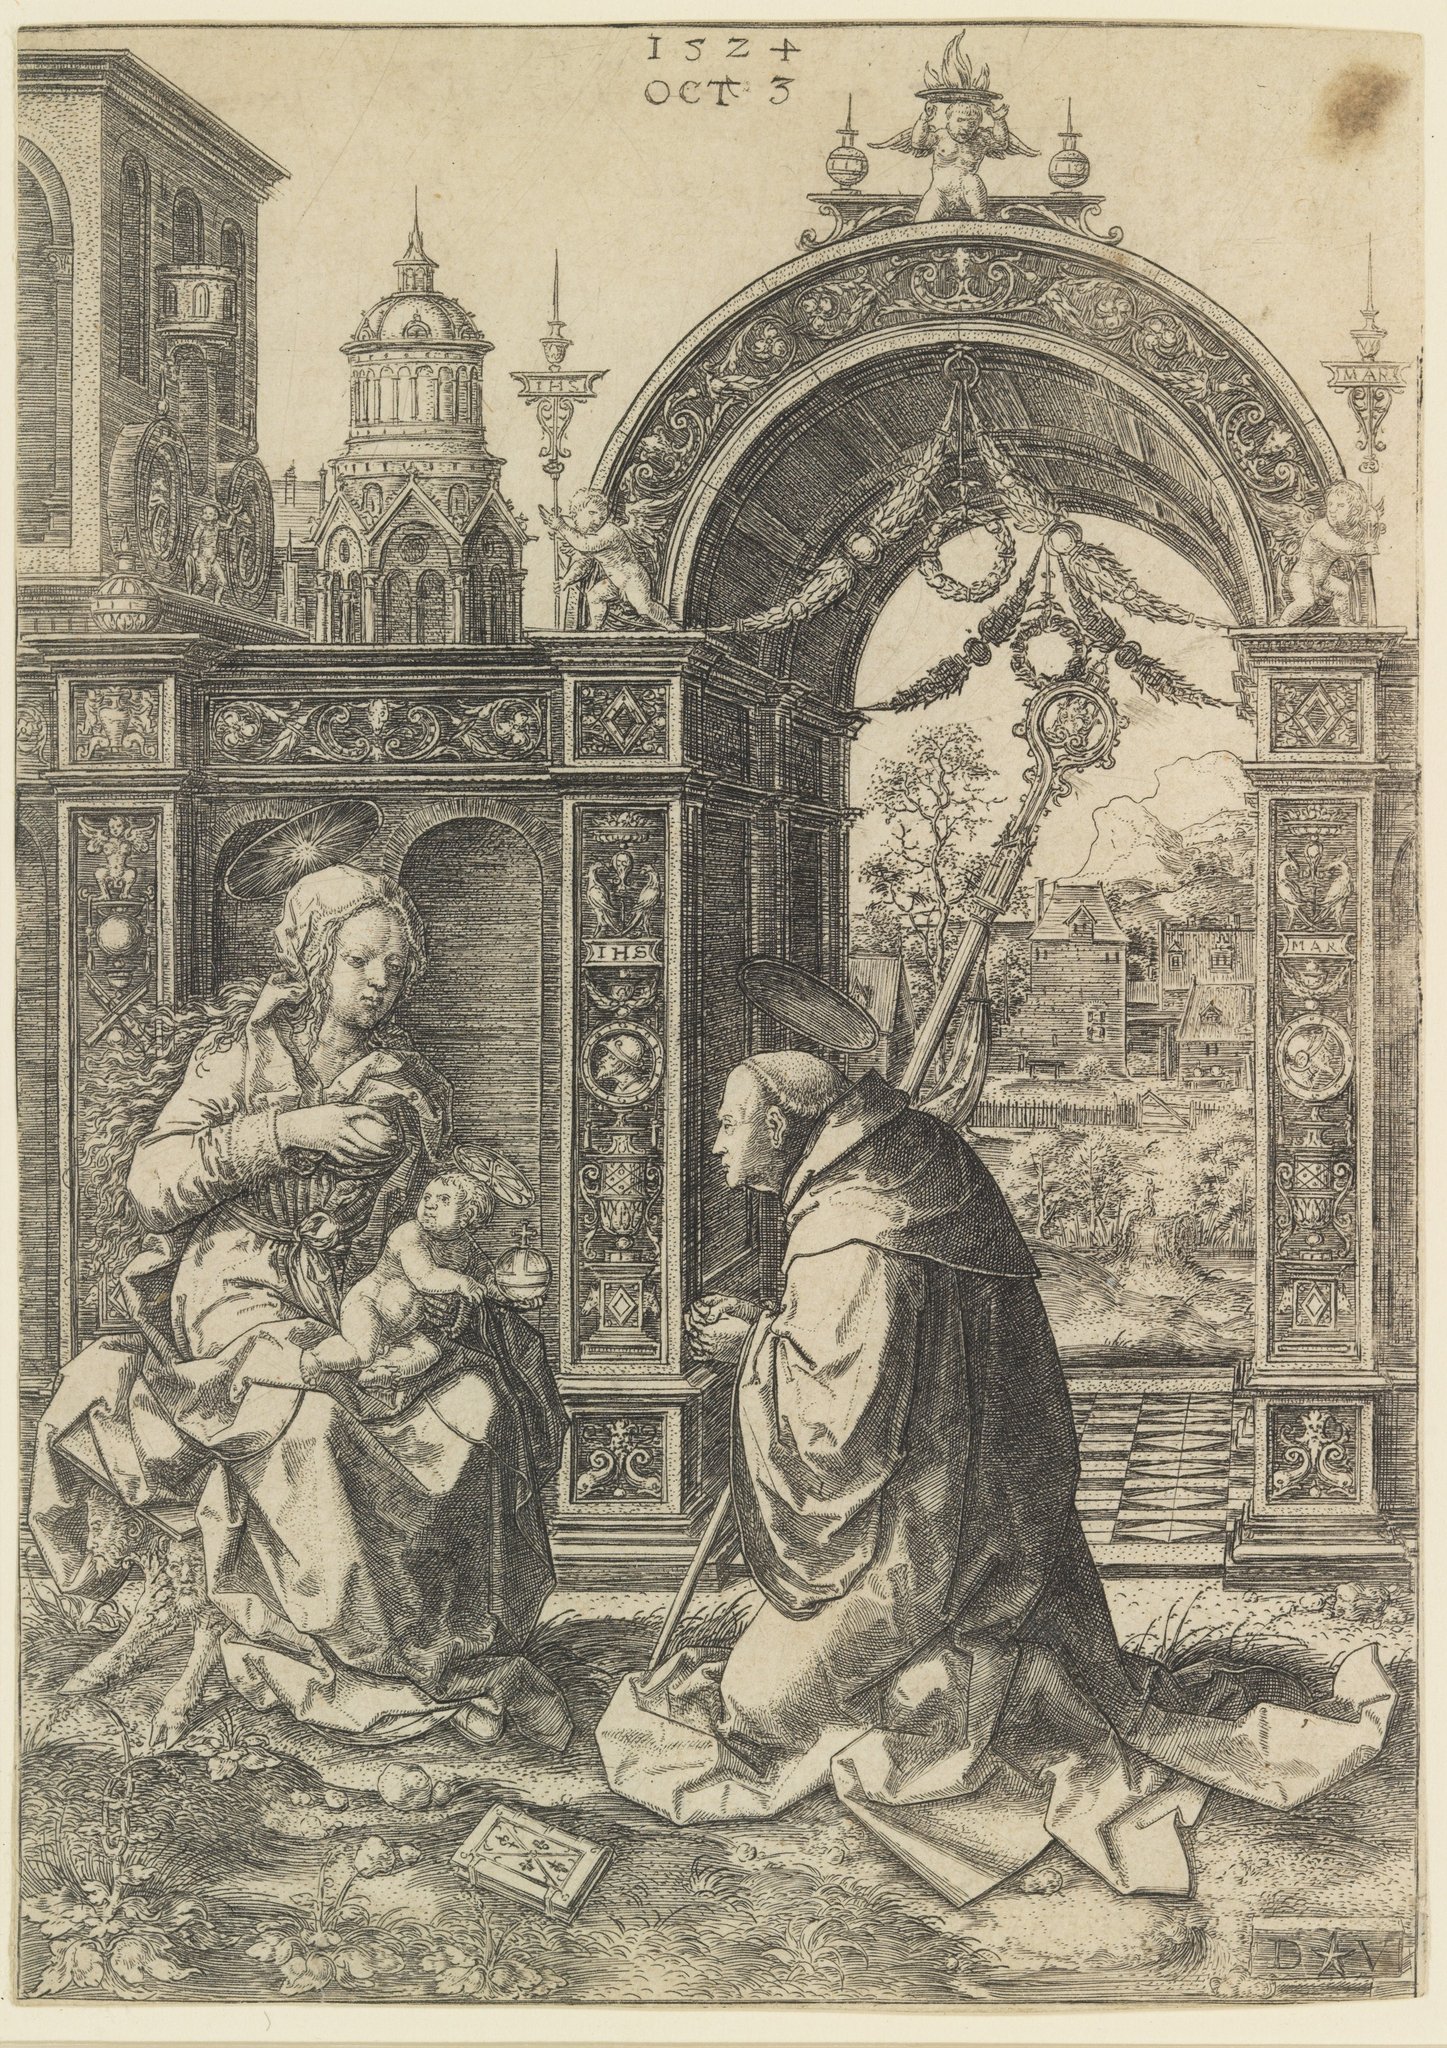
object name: print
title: St. Bernard Adoring the Christ Child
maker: dirck vellert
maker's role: artist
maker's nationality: netherlandish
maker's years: 1475-1552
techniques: engraving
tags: men,christ,virgin mary,saints